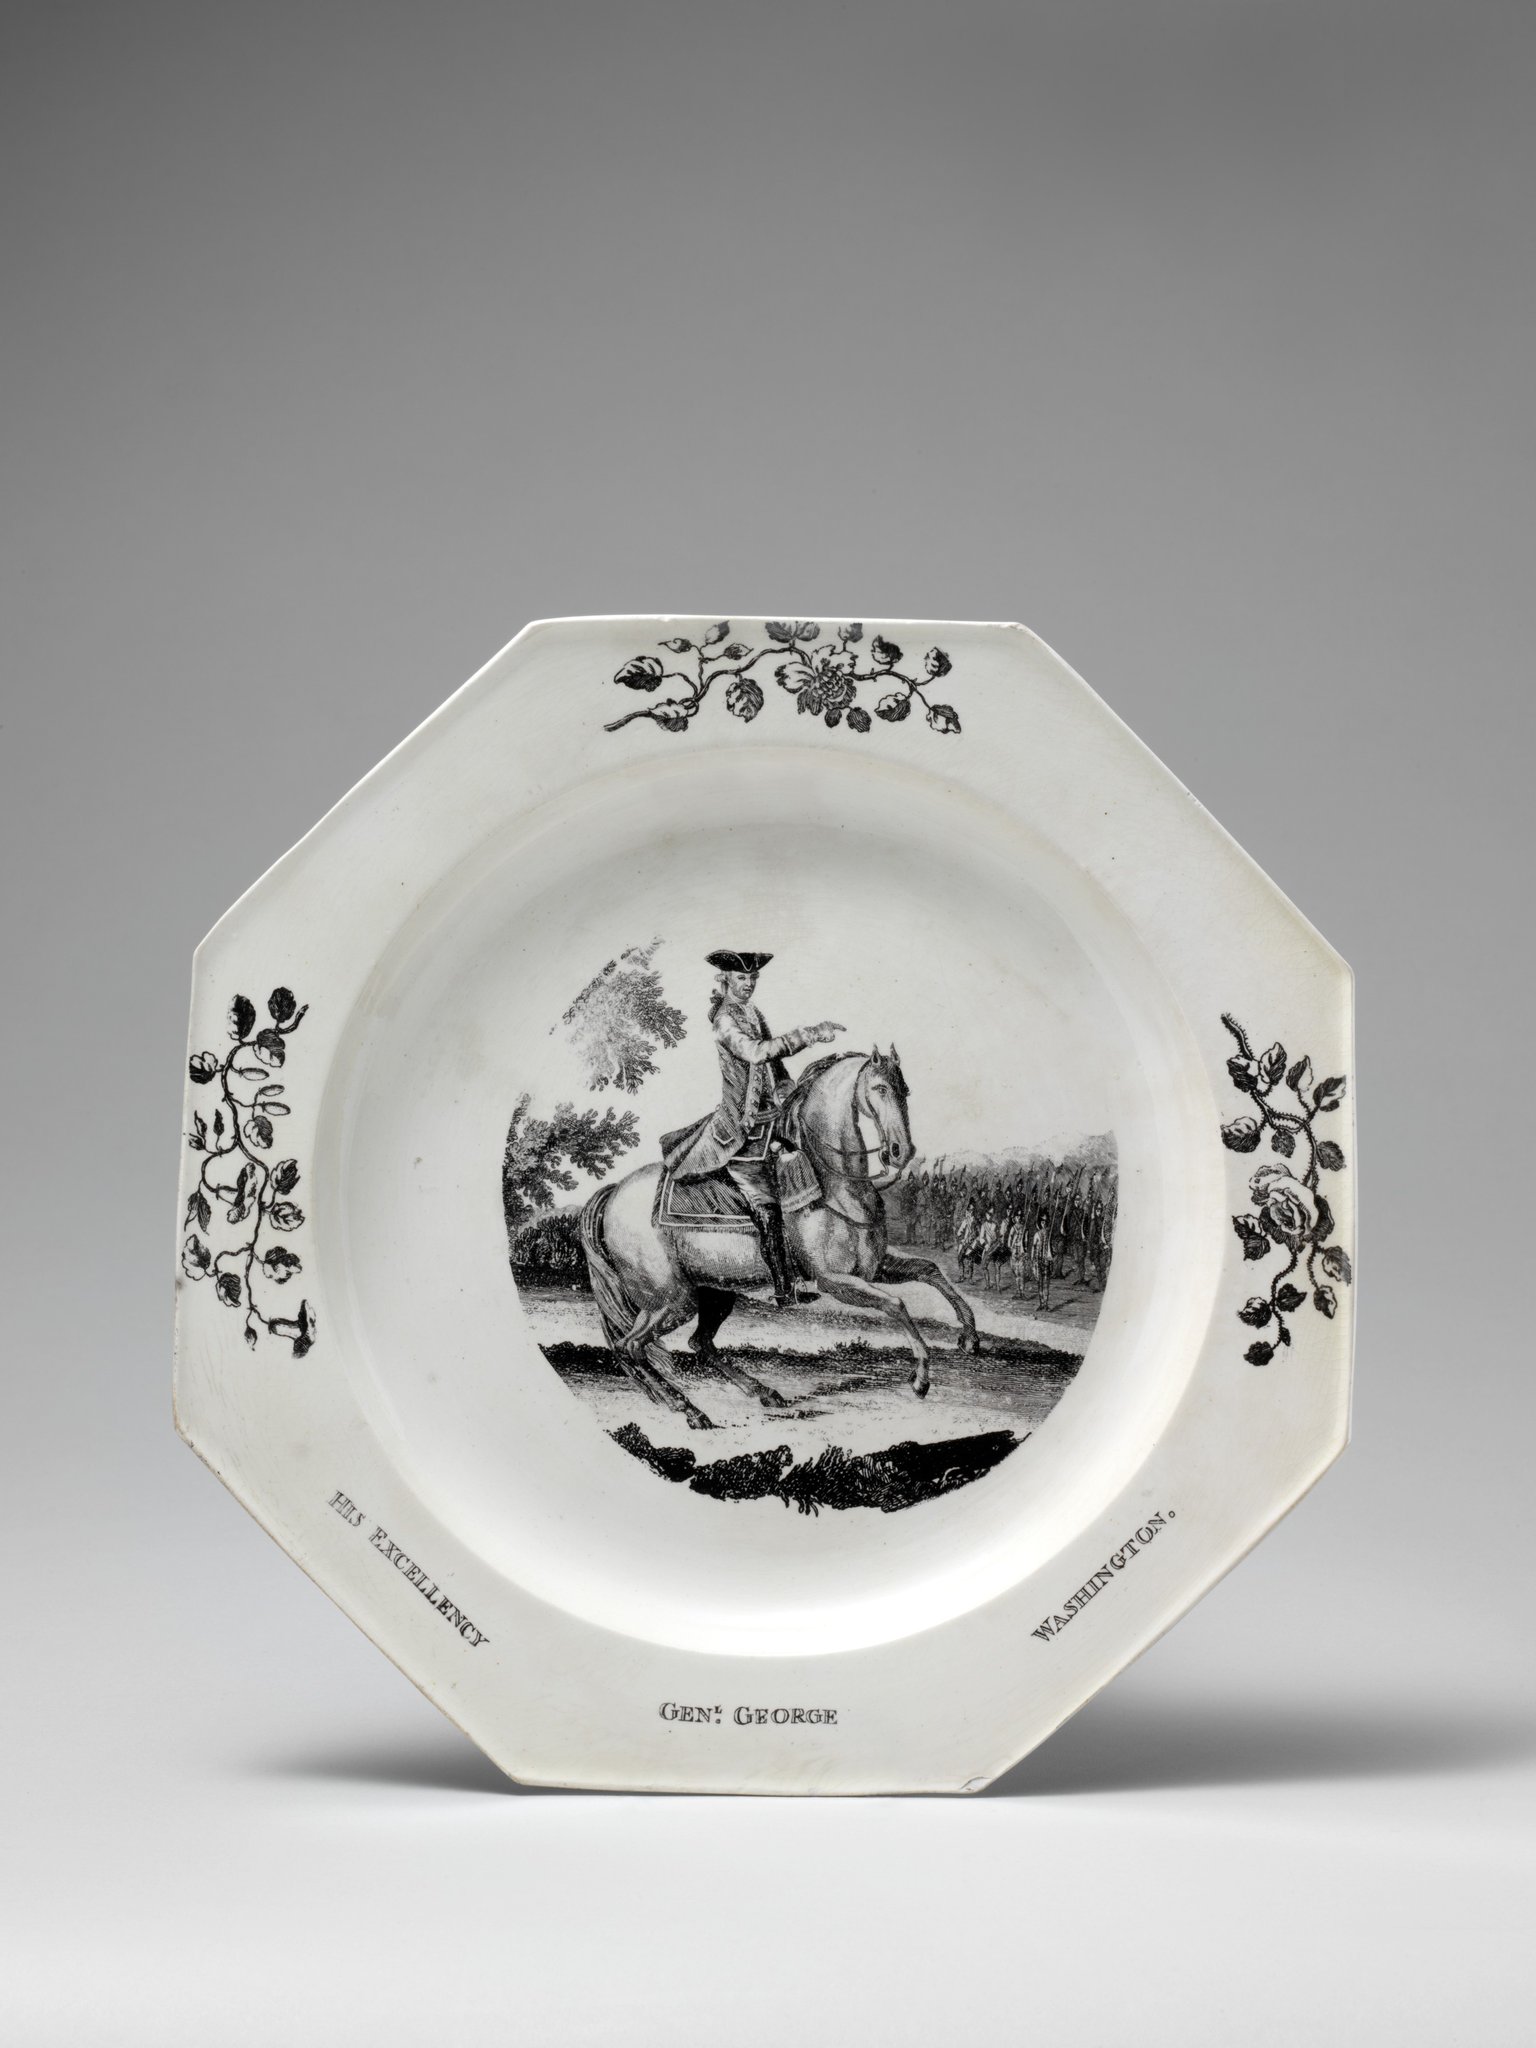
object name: plate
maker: sadler and green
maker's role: maker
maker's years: 1761-1777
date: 1752-1796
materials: earthenware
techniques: transfer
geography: england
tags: george washington,men,horses